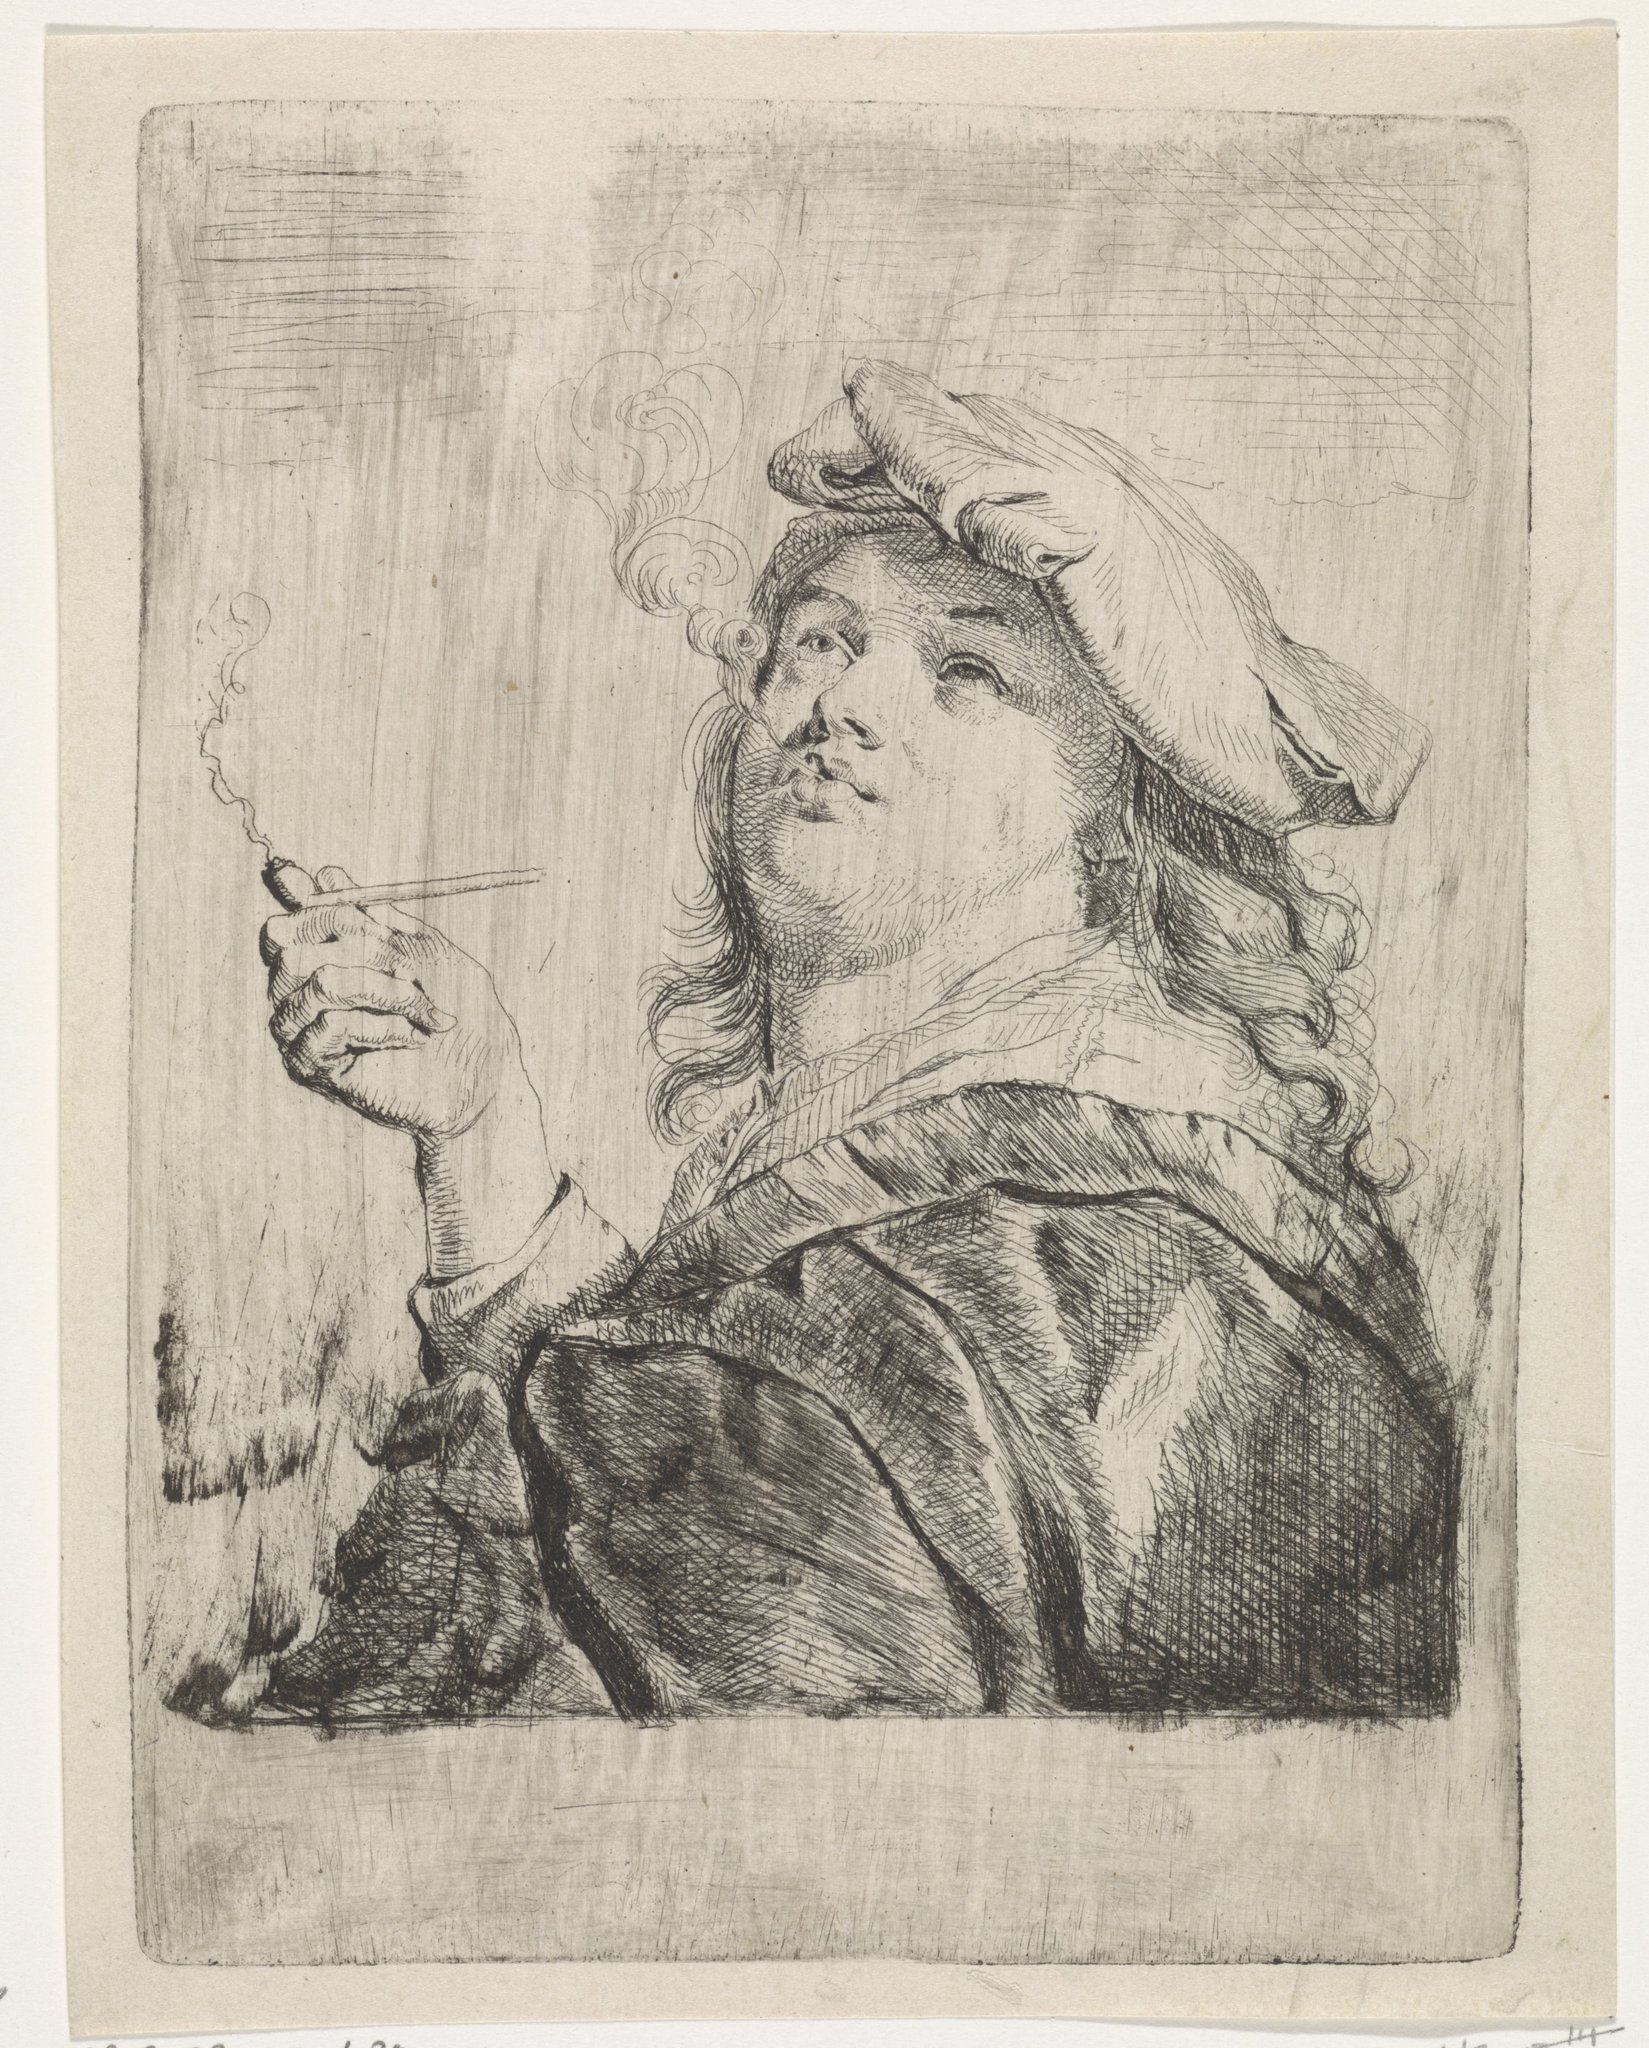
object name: print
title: Roker met een pijp in de hand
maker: carel de moor (ii)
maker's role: draughtsman, painter, print maker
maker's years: 1655-1738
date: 1665-1738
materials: paper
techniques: drypoint, etching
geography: netherlands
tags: head-gear: cap (+ men's clothes), pipe ~ tobacco (+ eating, drinking, smoking, chewing, etc. in secret, furtively)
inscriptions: collector's mark: Lugt 240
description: Een man met lange haren en een baret op het hoofd rookt een pijp.